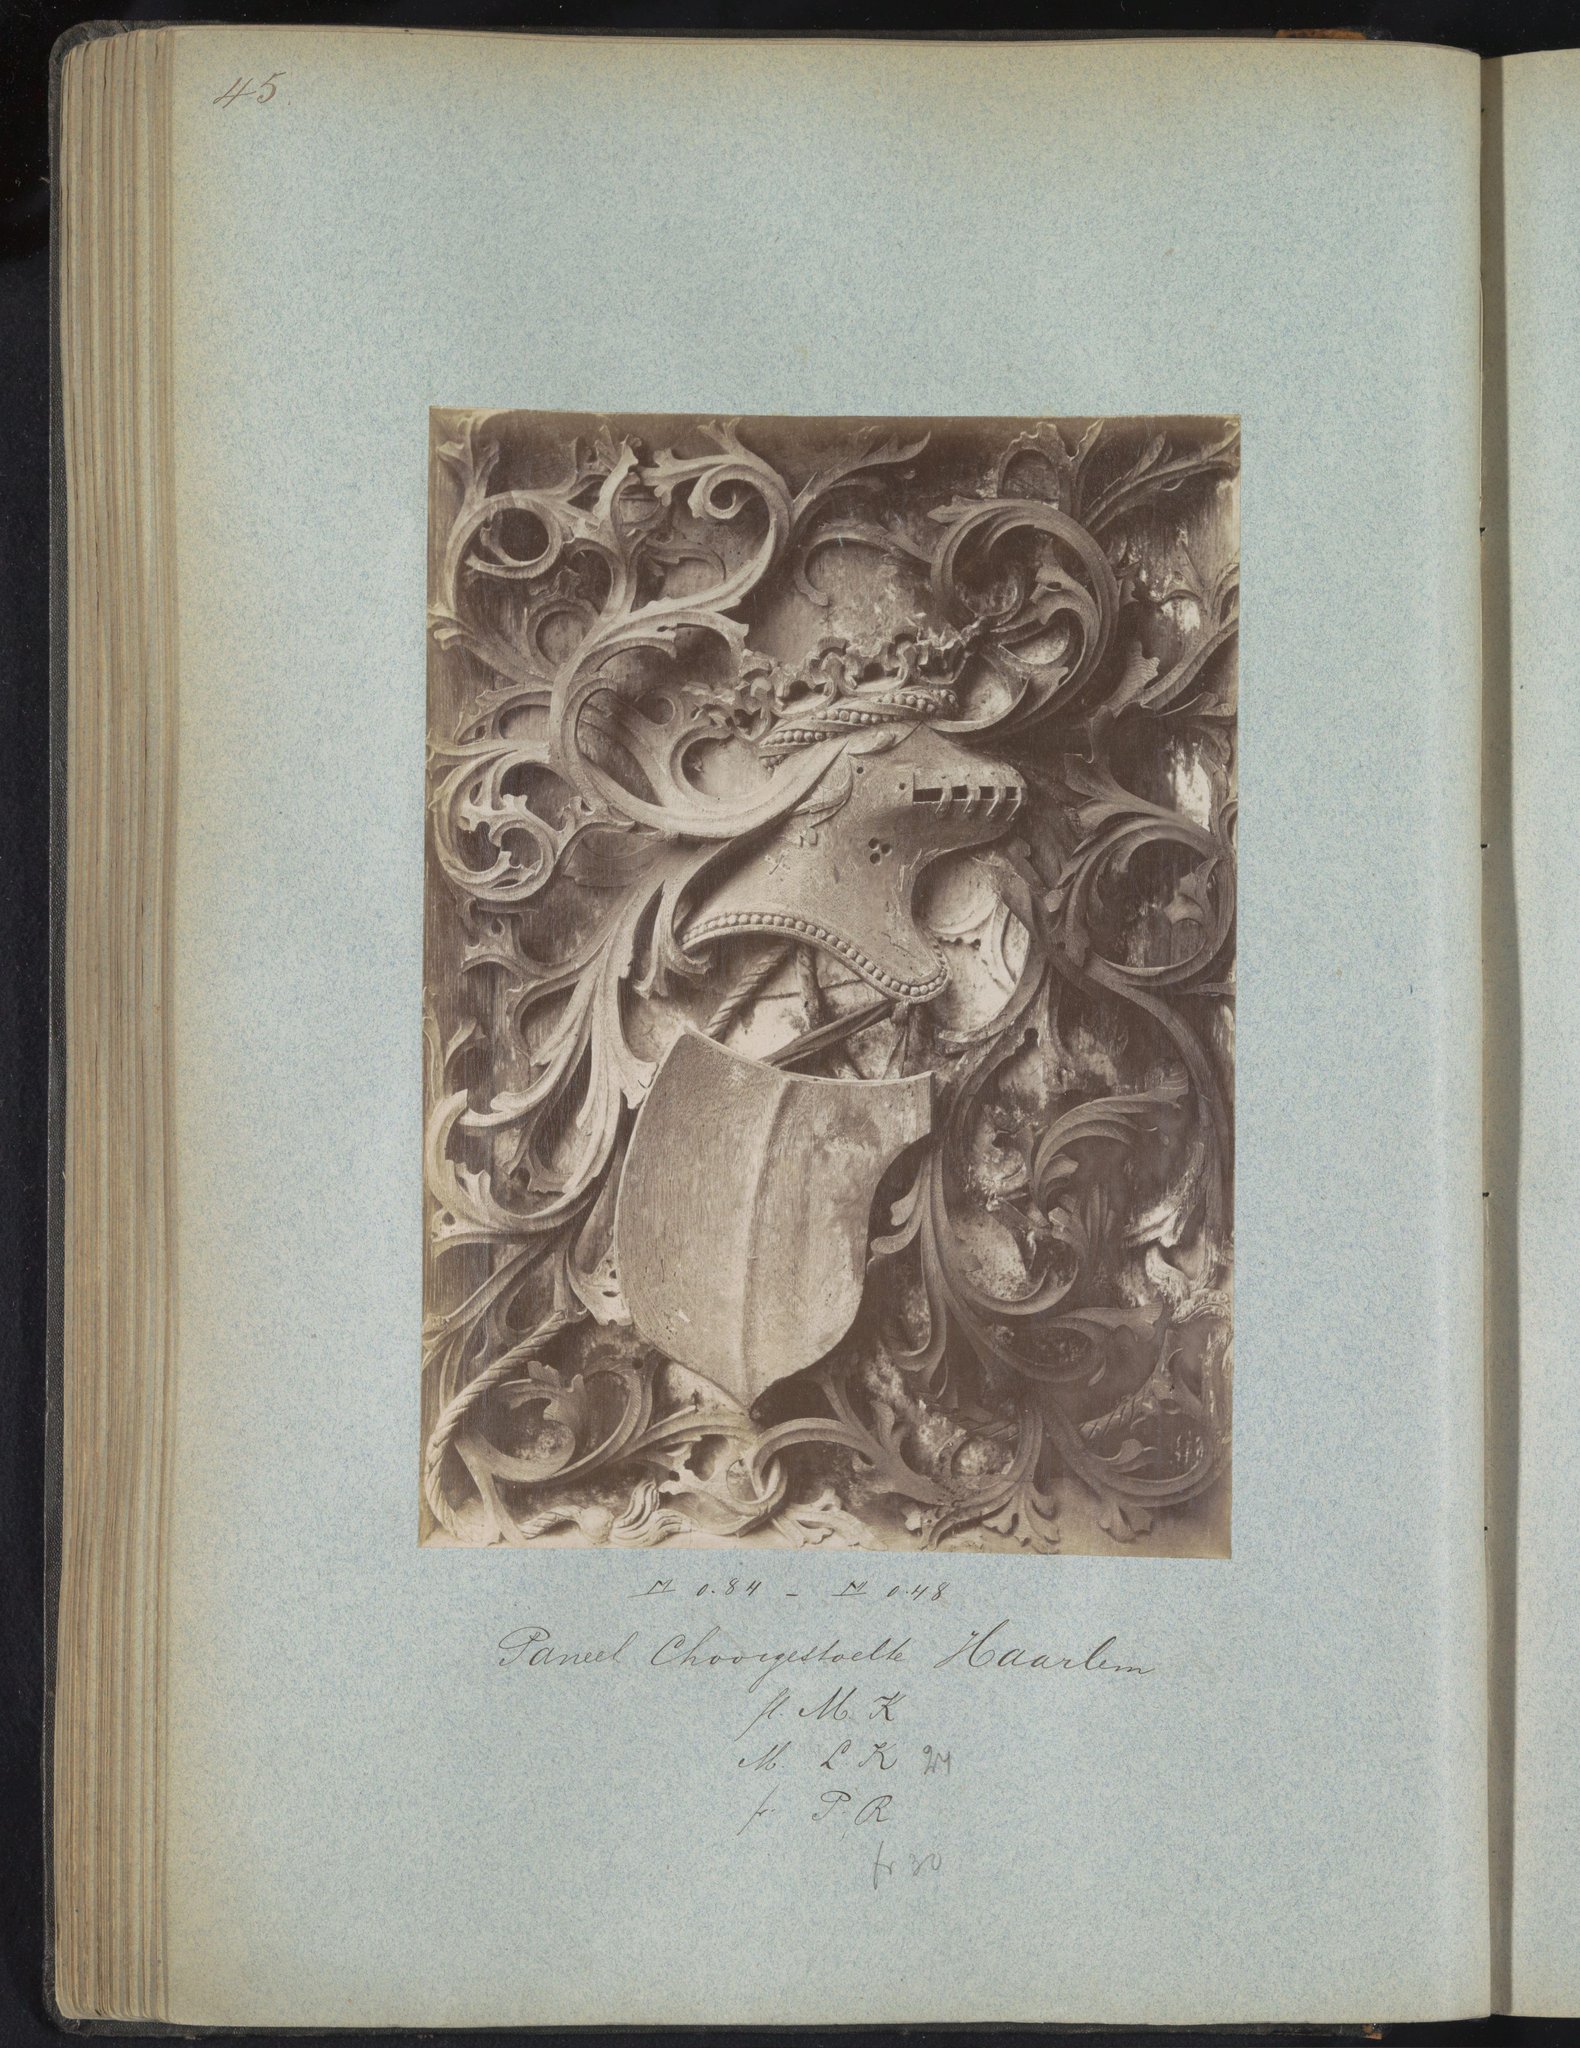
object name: photograph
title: Gipsen afgietsel van een paneel van een koorgestoelte te Haarlem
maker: Anonymous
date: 1875-1900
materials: paper, photographic support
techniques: albumen print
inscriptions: annotation, annotation: ‘M 0.84 - M 0.48’, annotation: ‘Paneel koorgestoelte Haarlem’